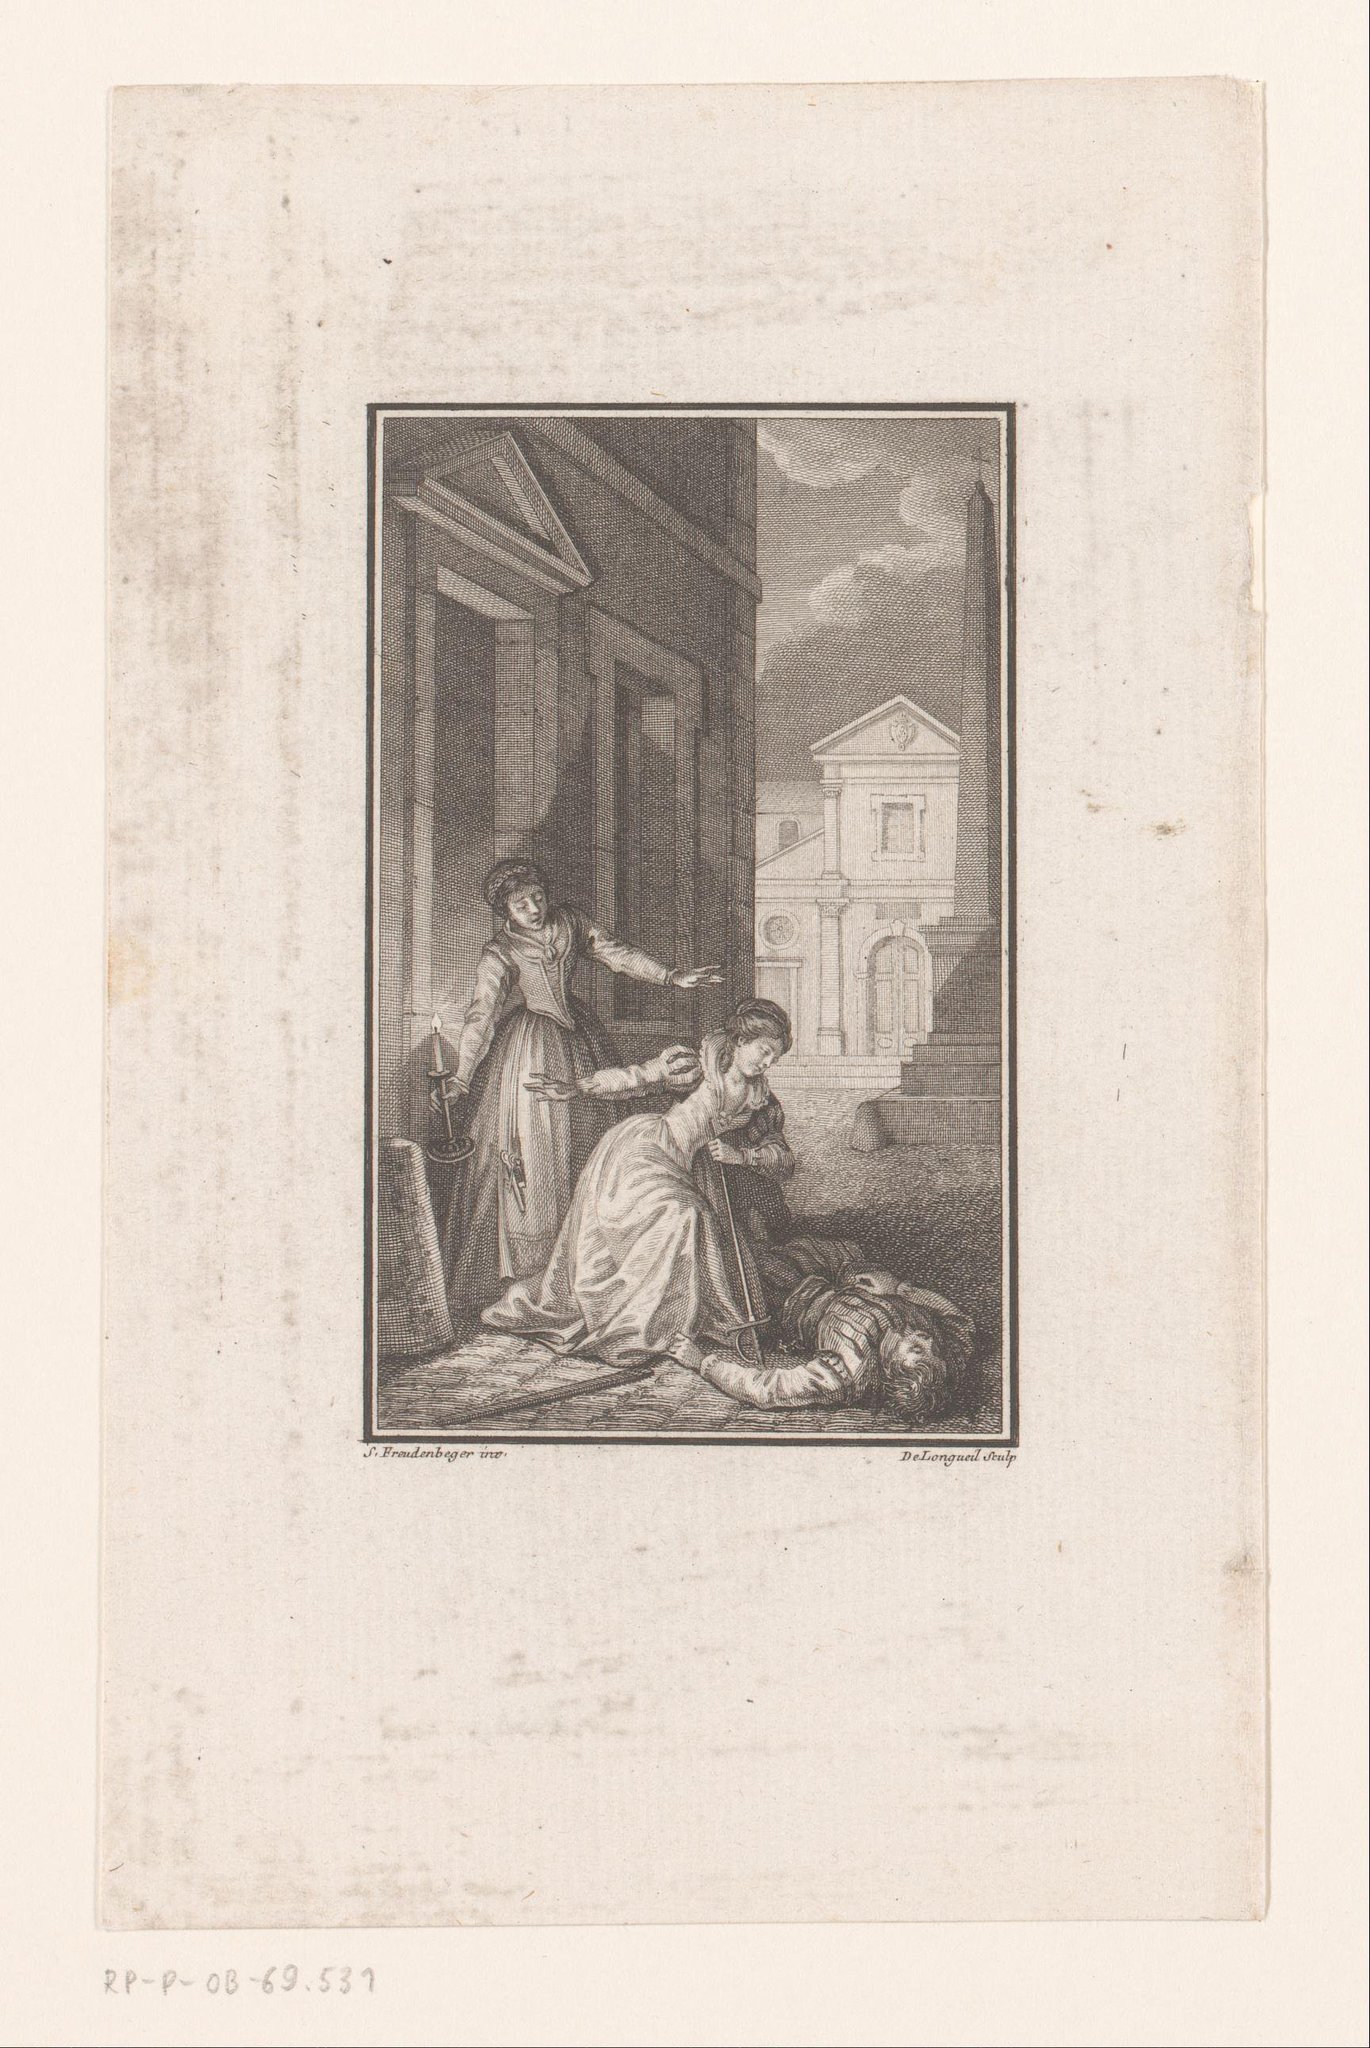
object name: book illustration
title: Vrouw met zwaard en dienstmeid bij een dode man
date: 1780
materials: paper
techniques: engraving, etching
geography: france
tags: finding a dead person, hacking and thrusting weapons: sword, maid ~ house personnel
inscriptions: collector's mark: Lugt 2228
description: Prent uit: Margaretha van Frankrijk. Les nouvelles de Marguerite, reine de Navarre. Bern: La Nouvelle Société Typographique, 1780.